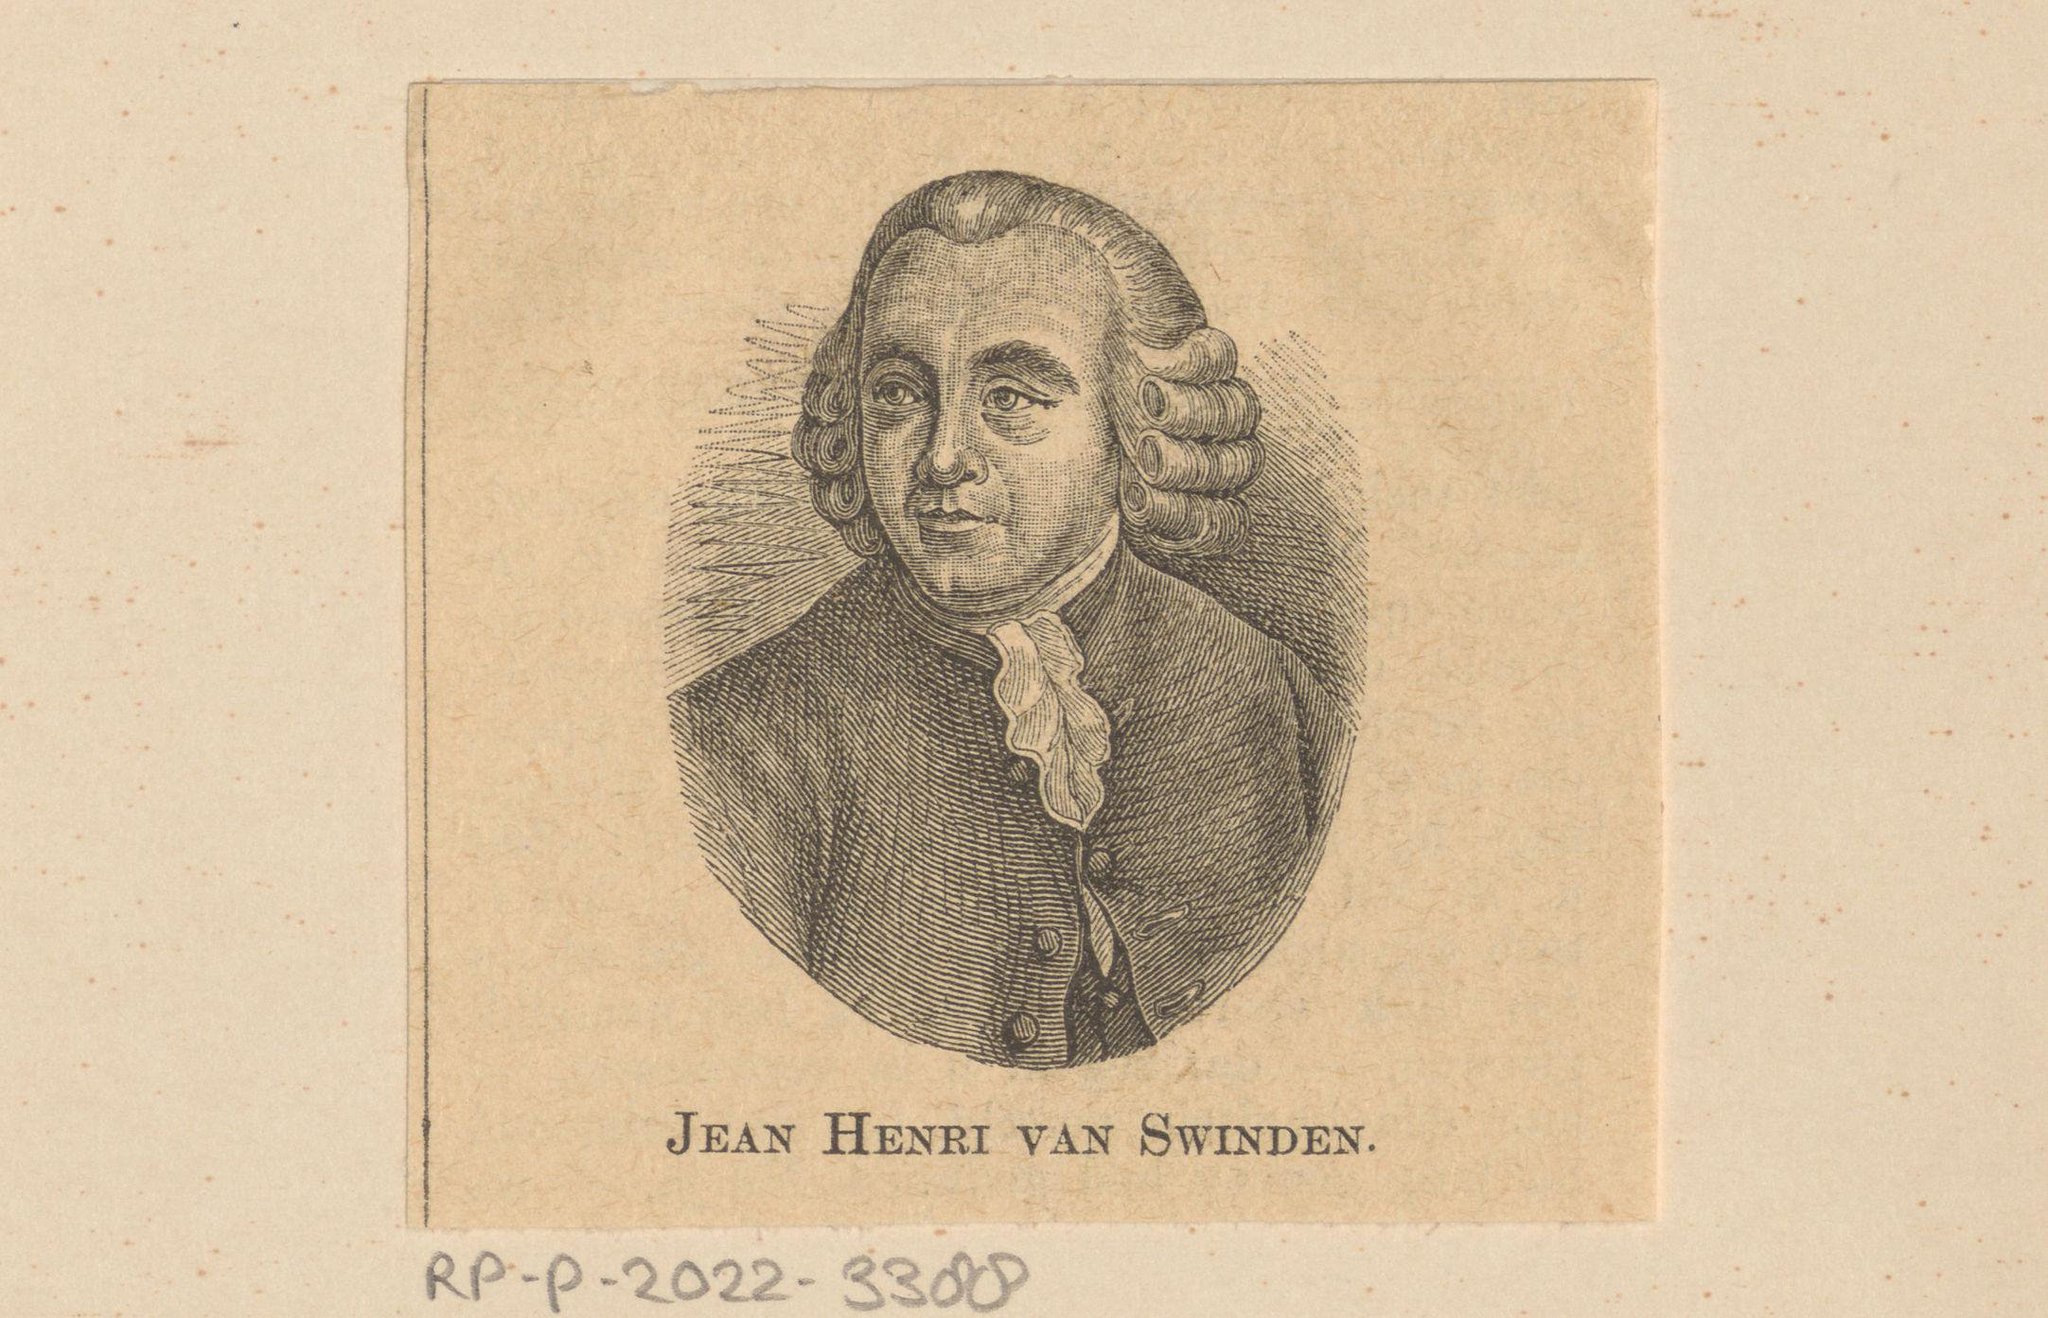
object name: book illustration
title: Portret van Jean Henri van Swinden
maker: Anonymous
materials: paper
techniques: engraving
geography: netherlands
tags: the hague, amsterdam, physicist, jean henri van swinden, historical persons, professor